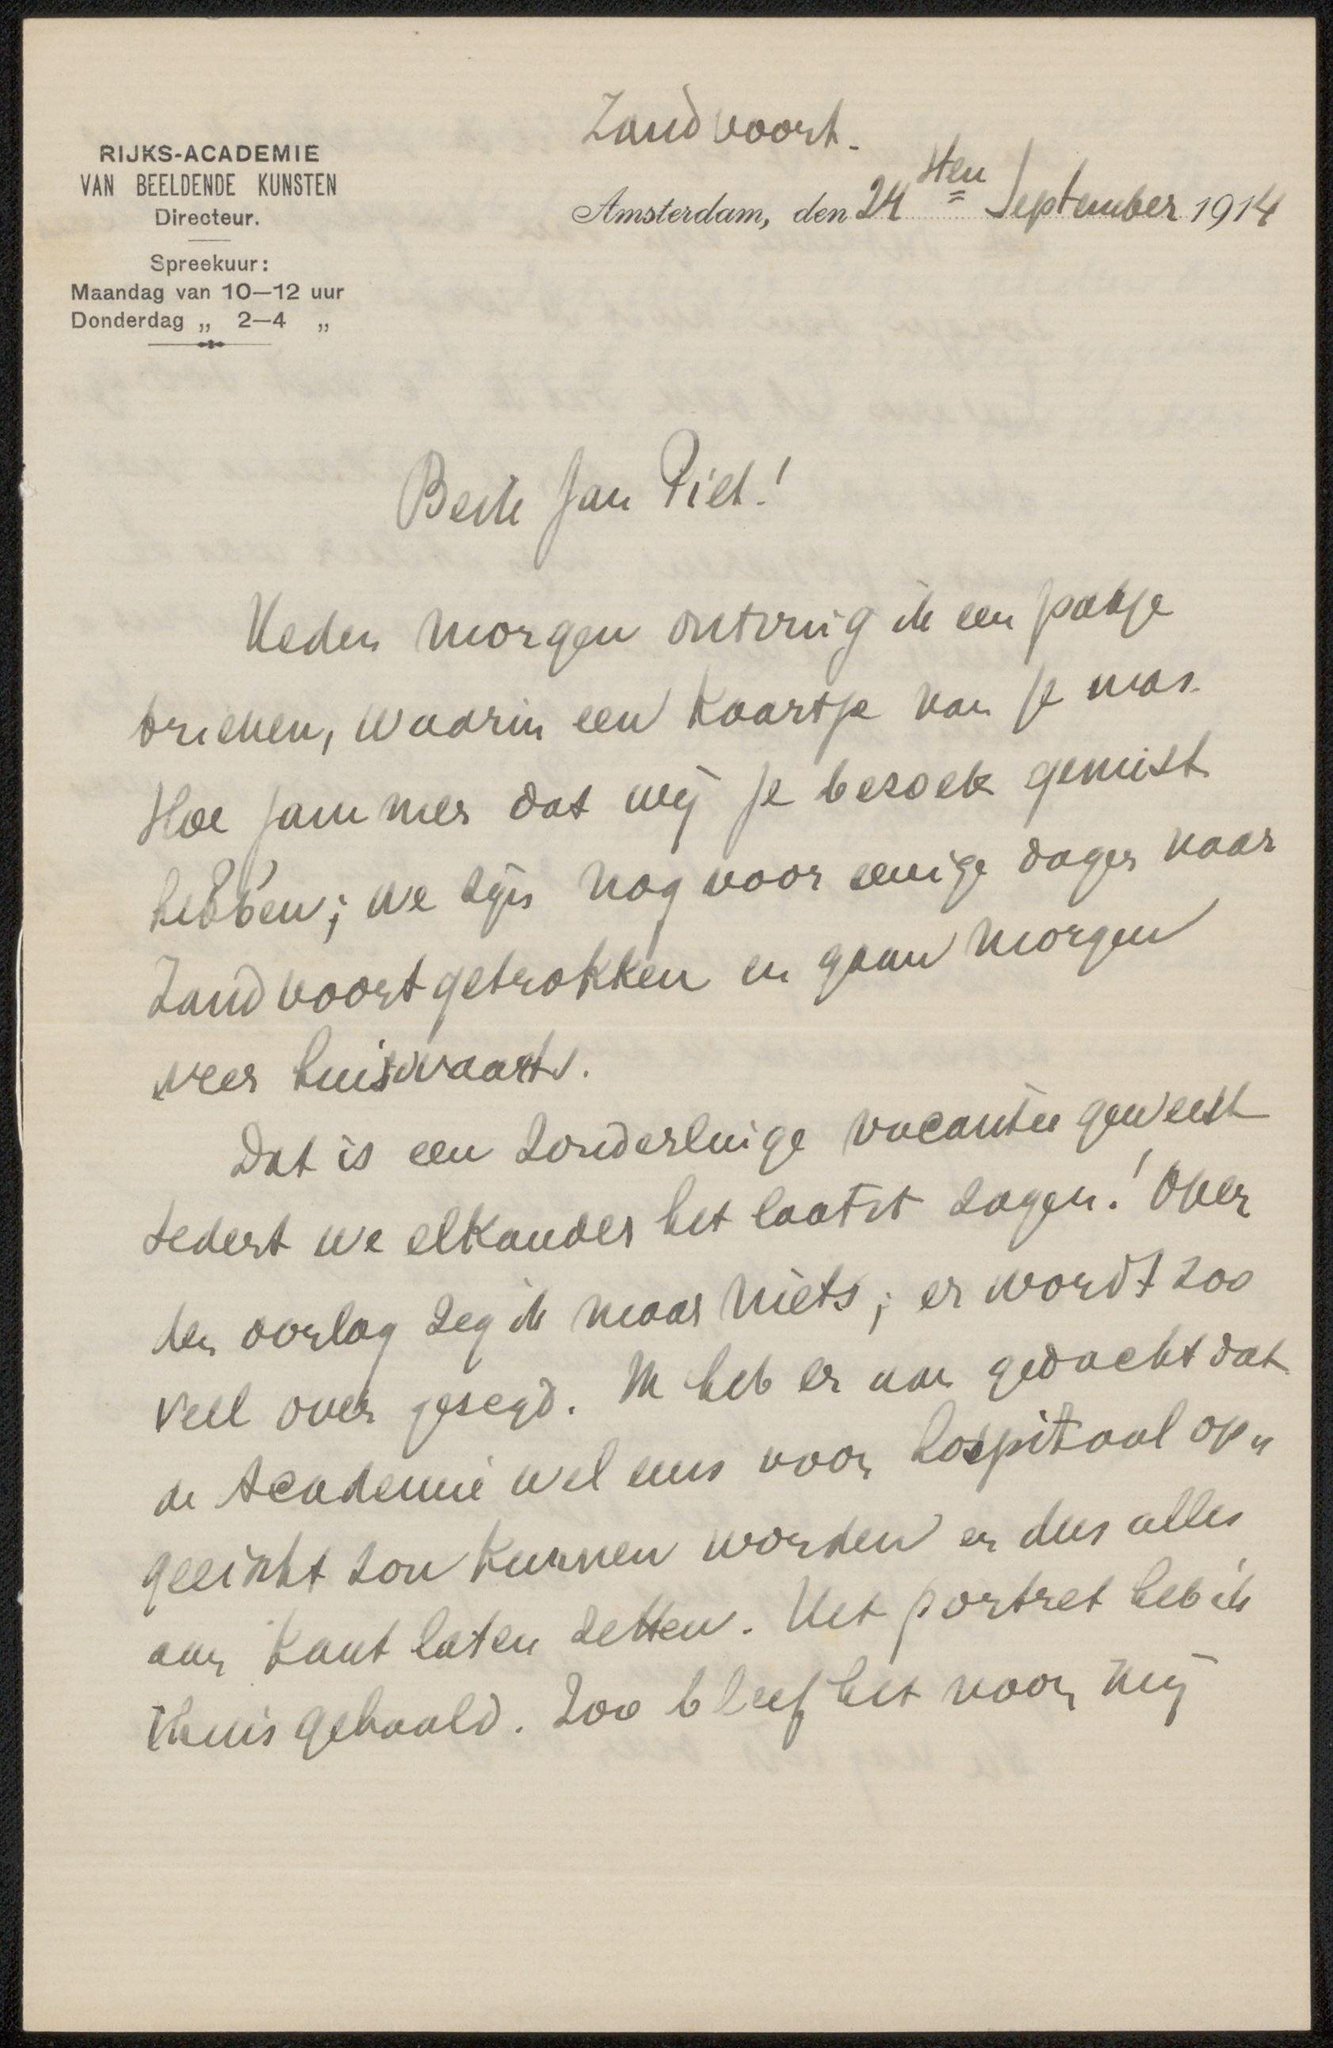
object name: letter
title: Brief aan Jan Veth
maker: antoon derkinderen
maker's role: draughtsman, painter, print maker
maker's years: 1859-1925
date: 1914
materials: ink, paper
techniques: pen, printing, writing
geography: zandvoort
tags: dordrecht, designer, jan veth, artist's model, sitter, travelling; tourism, workshop, studio of the artist (in general), historical persons (portraits and scenes from the life), money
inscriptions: collector's mark: ‘RPK’